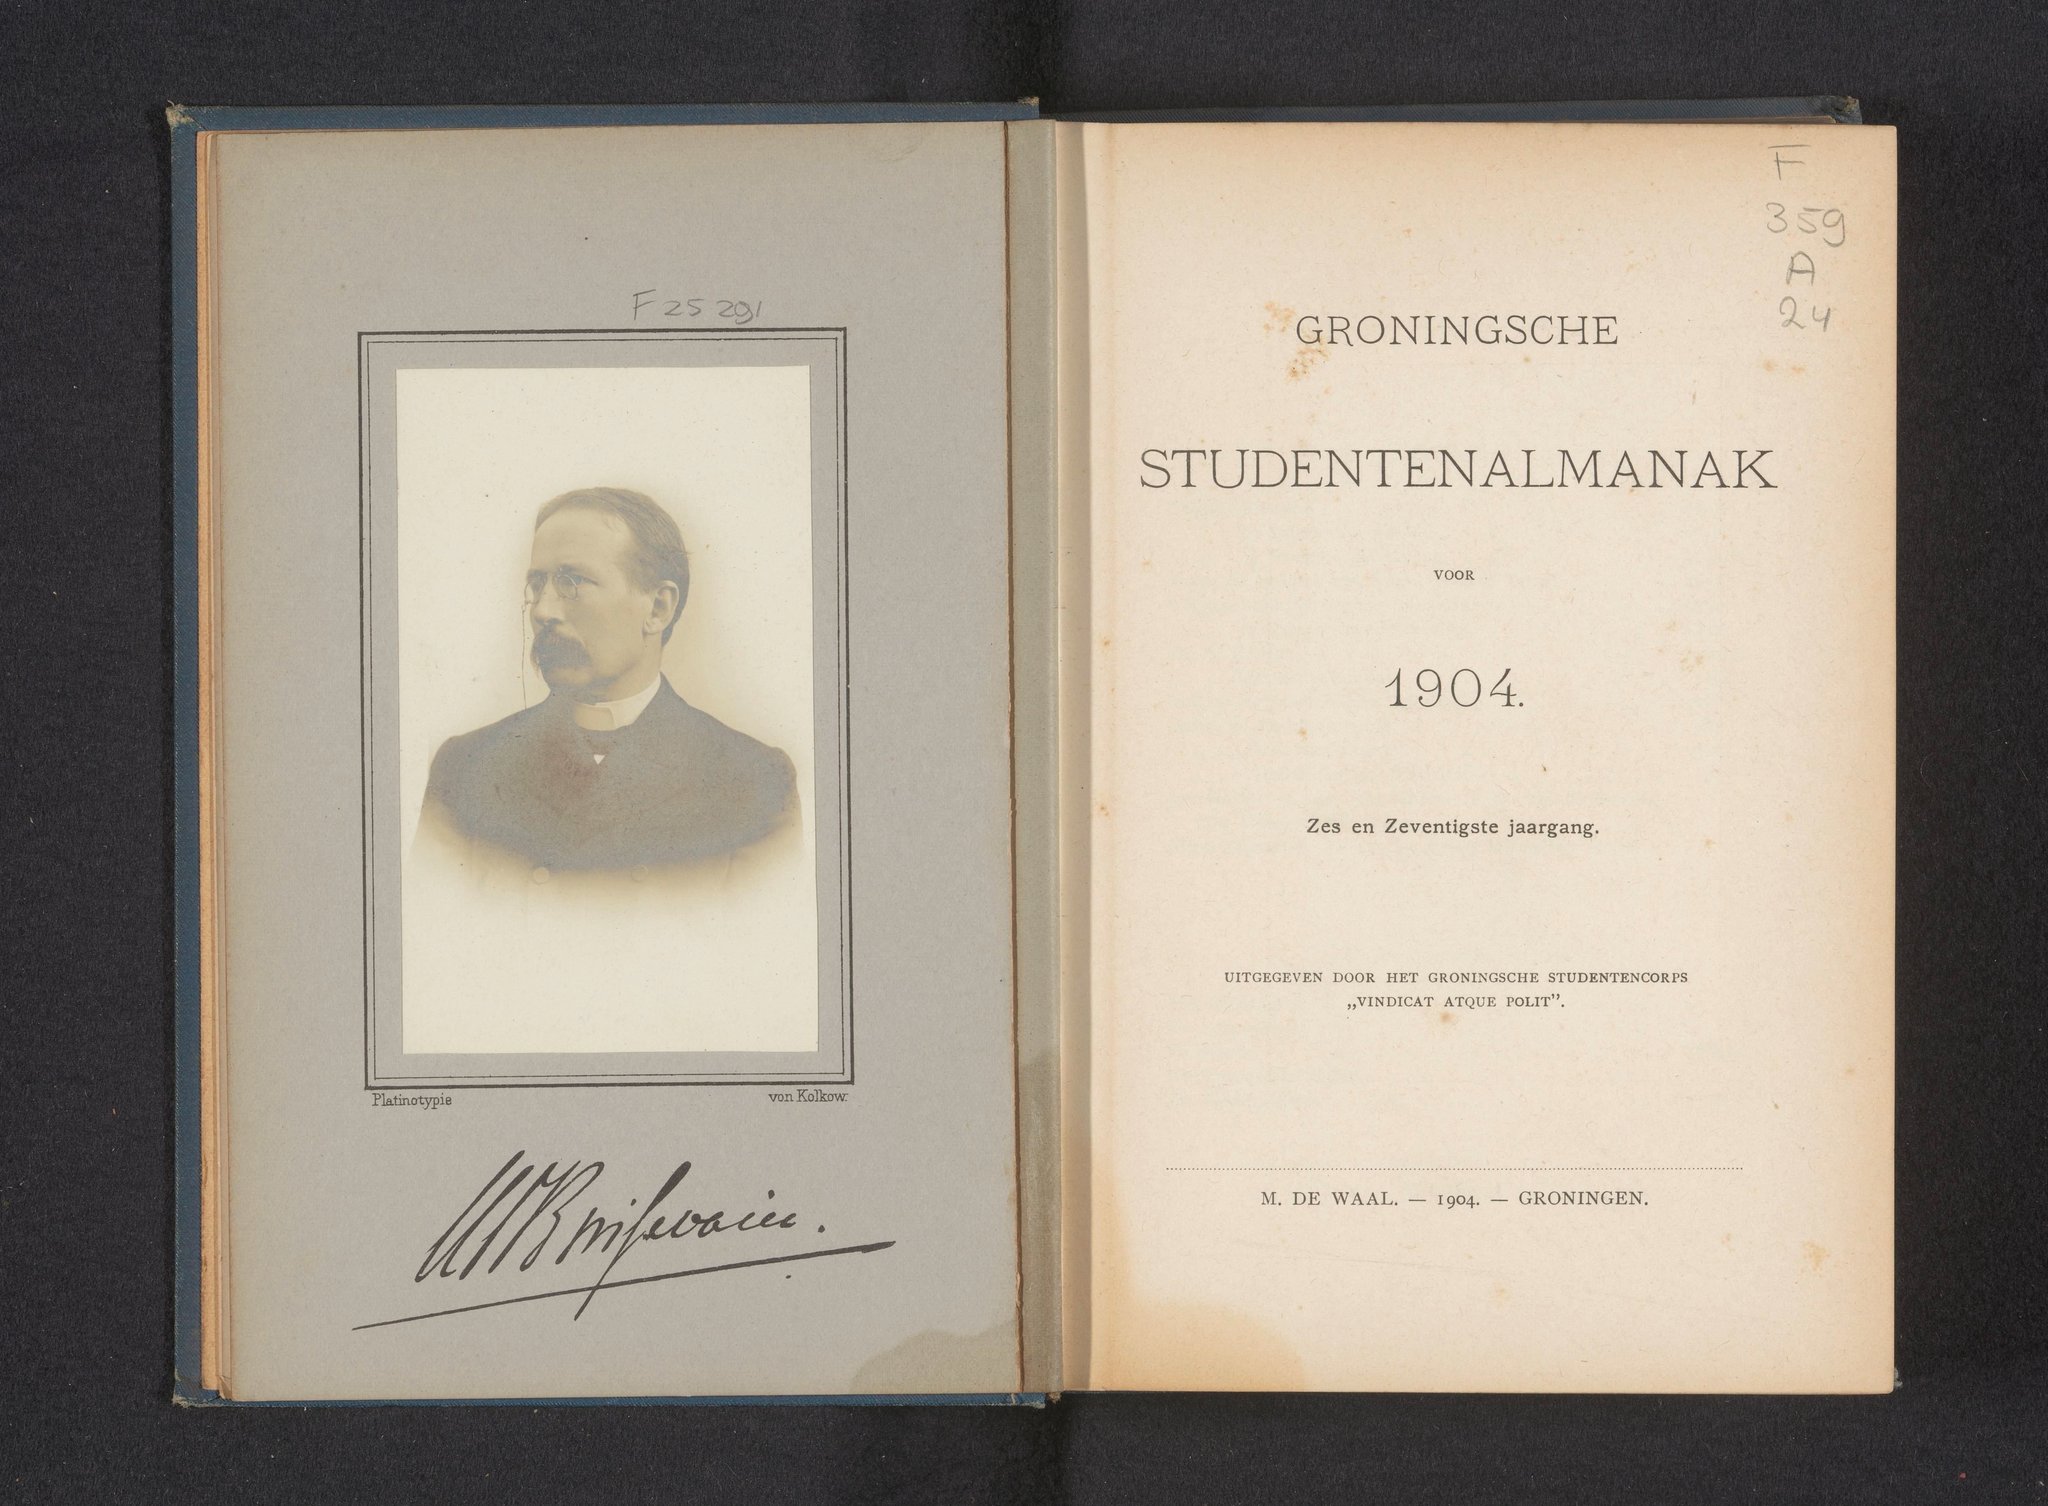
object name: book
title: Groninger studenten almanak voor het jaar 1904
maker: m. de waal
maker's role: publisher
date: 1904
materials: cardboard, linen, paper, photographic support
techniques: gelatin silver print, printing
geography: groningen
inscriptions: annotation: ‘gekocht oktober 1965/ bij Academia, Groningen/ voor f 5.90’, number: ‘f 5.90’